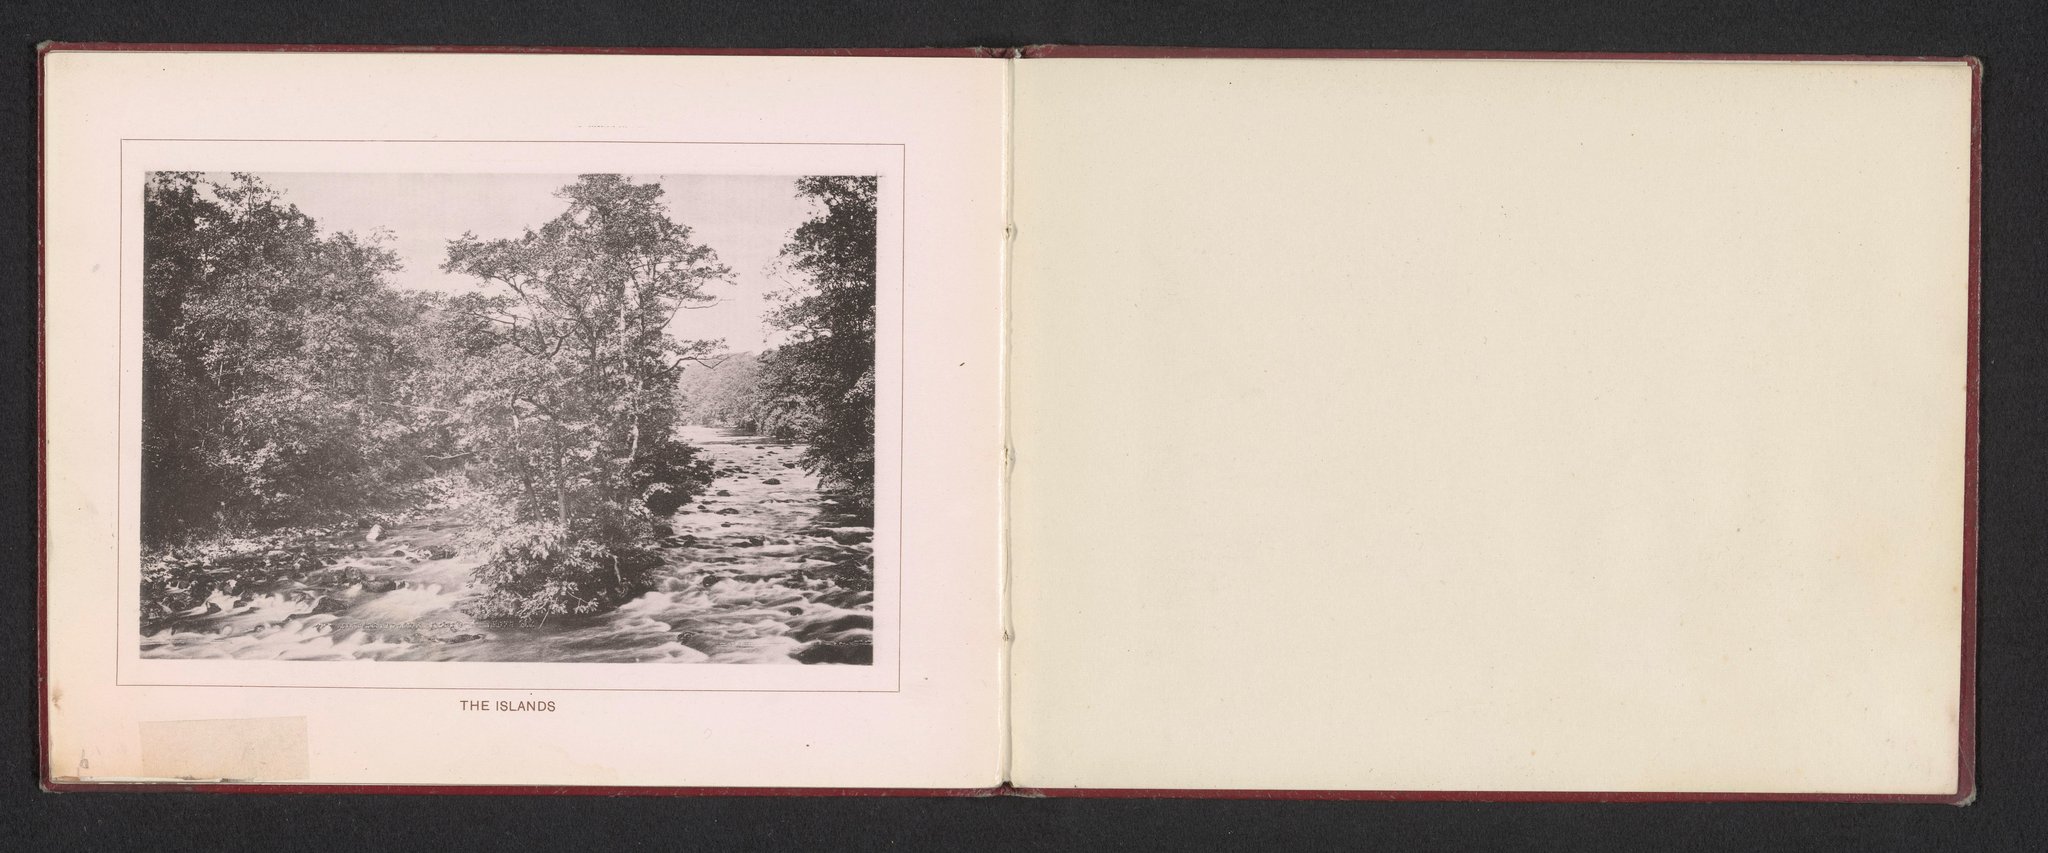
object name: photomechanical print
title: The islands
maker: Anonymous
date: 1890-1900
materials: linen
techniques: photograph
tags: island, river